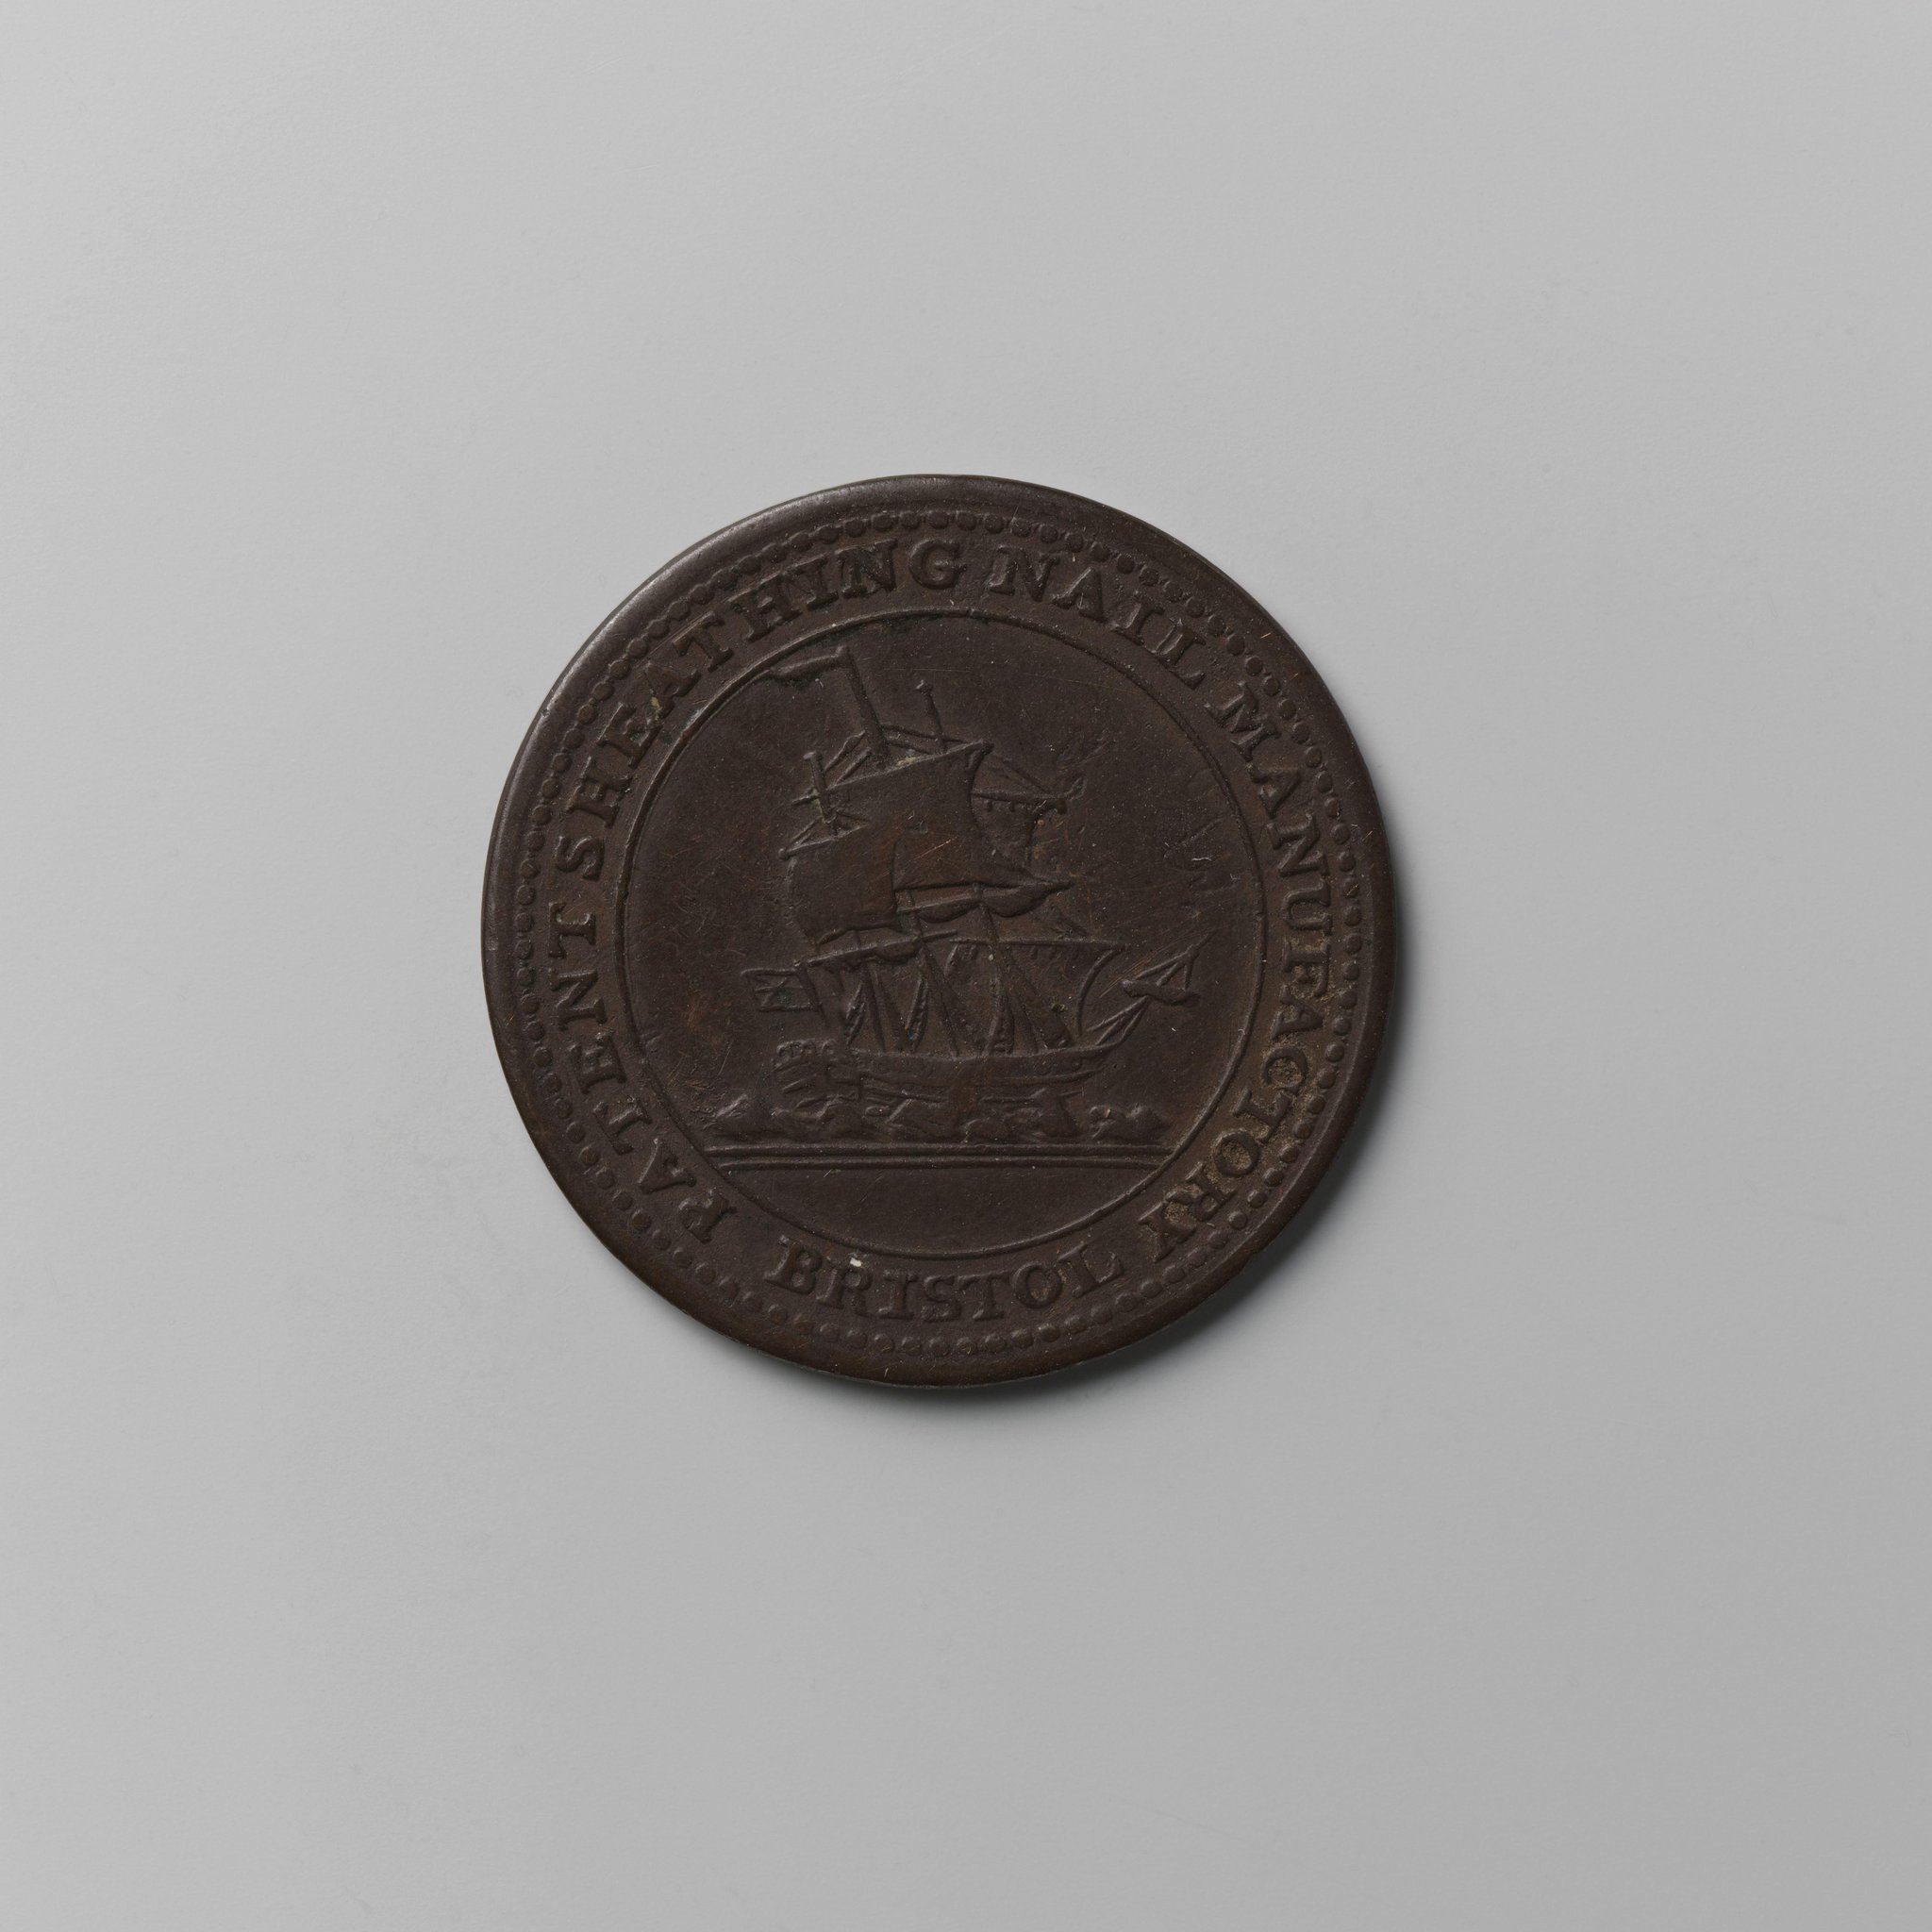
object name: farthing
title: Token voor een farthing uit Bristol, Engeland, 1811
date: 1811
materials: copper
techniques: striking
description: Koperen particuliere munt. Voorzijde: schip met volle zeilen op zee. Keerzijde: in drie regels waarde-aanduiding. Kabelrand.